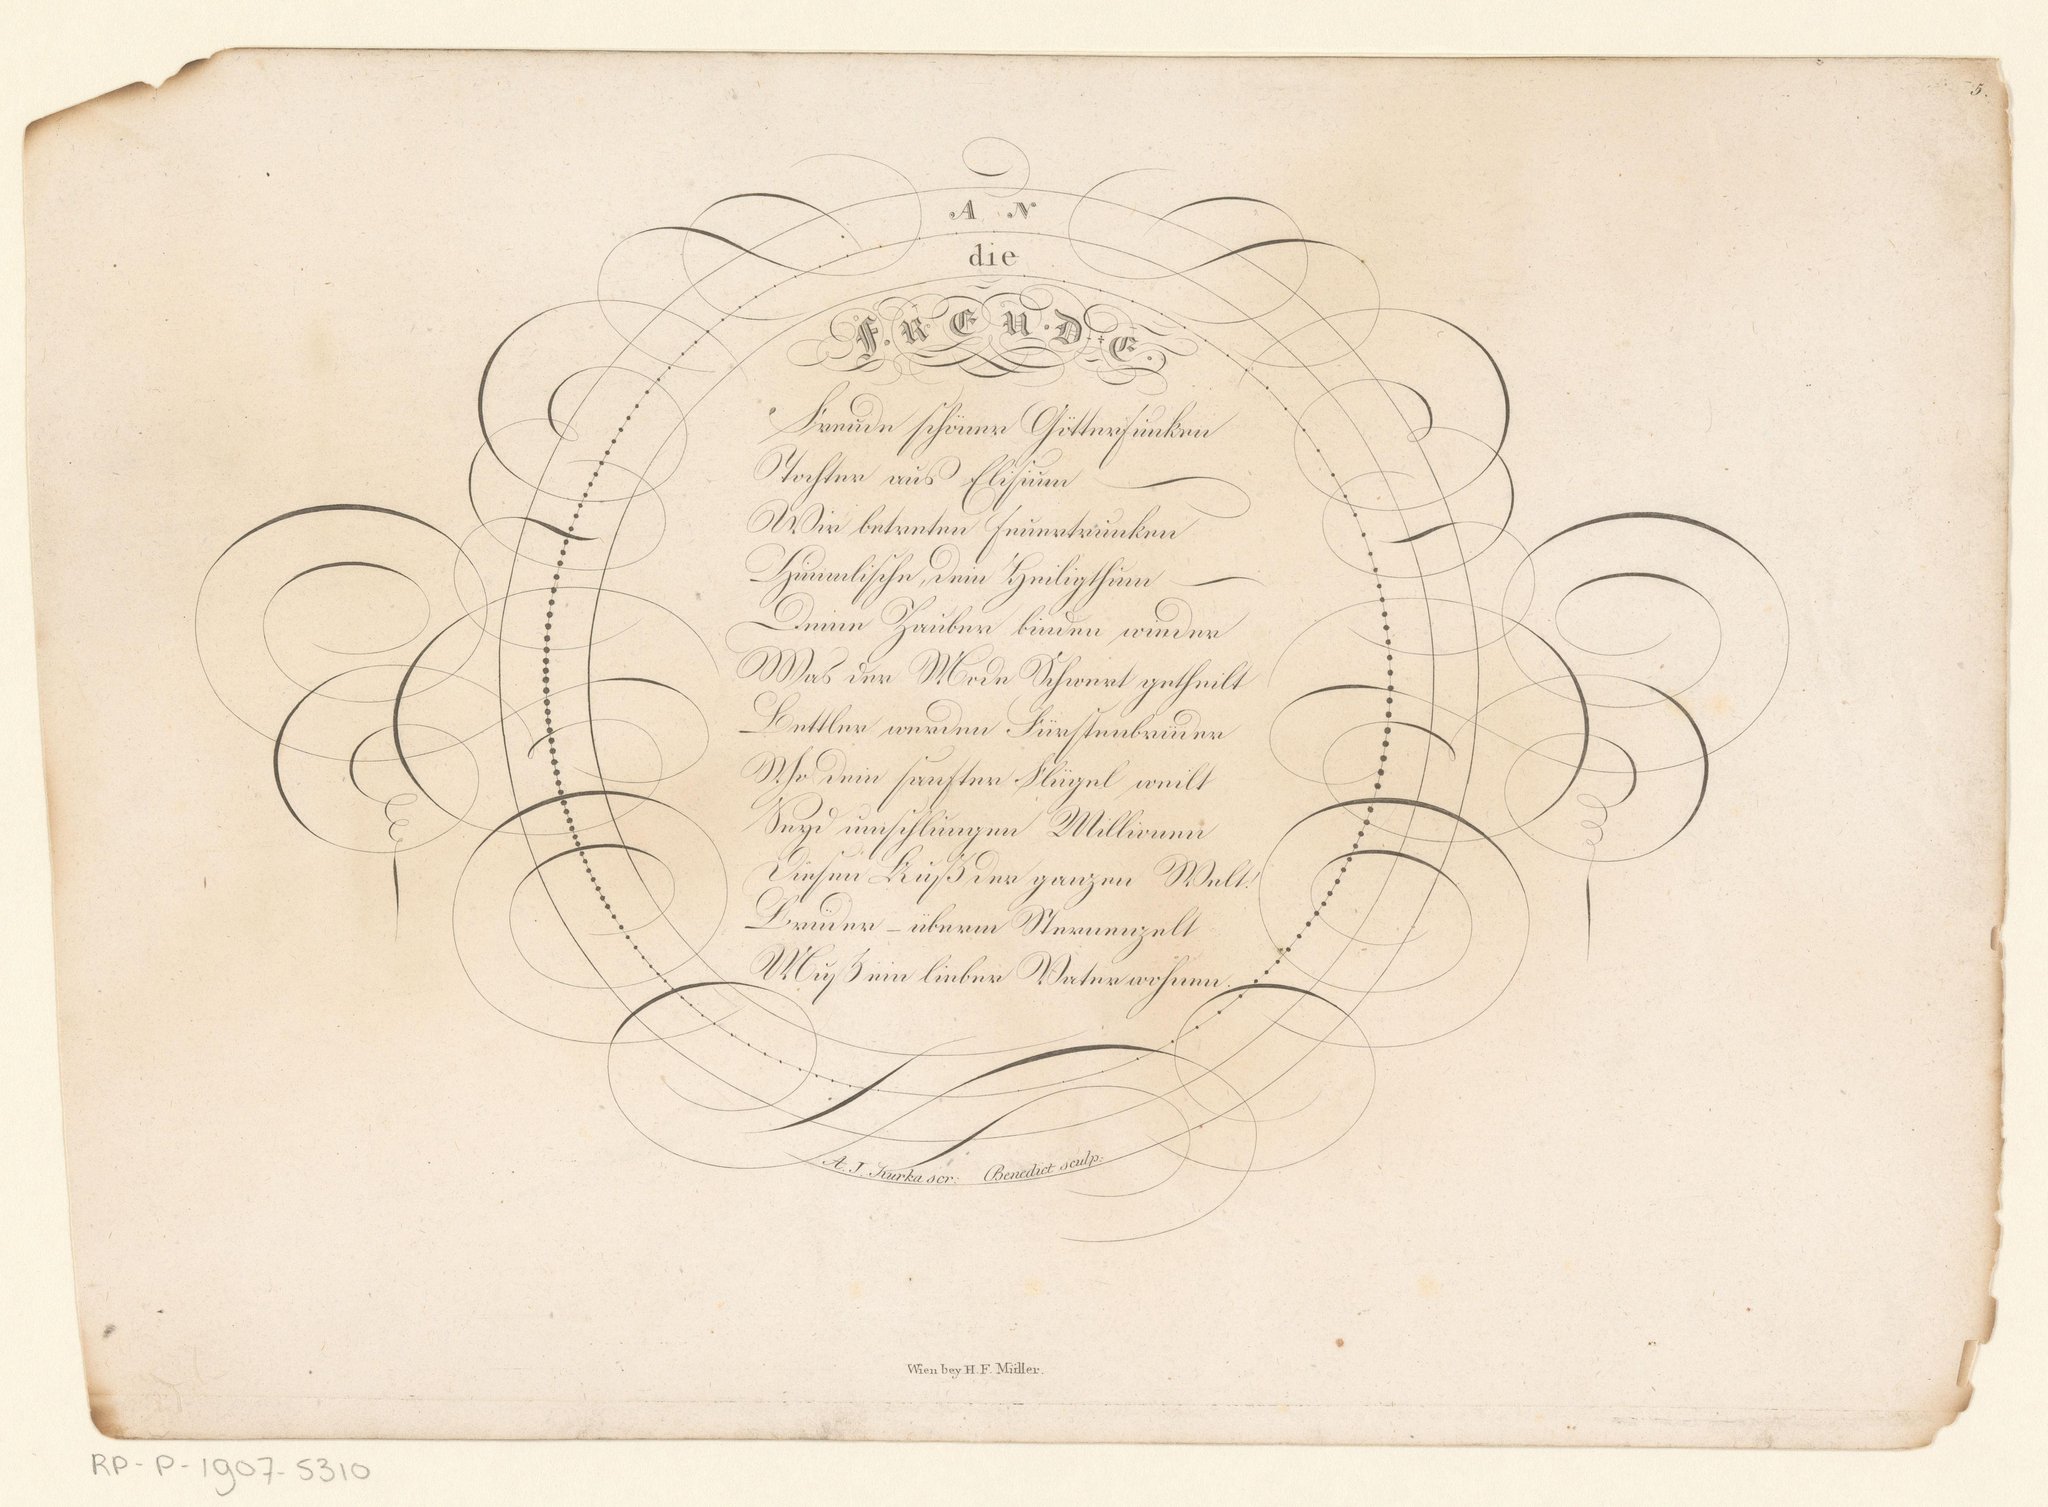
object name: ornament print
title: Schrijfvoorbeeld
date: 1795-1850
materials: paper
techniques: engraving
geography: vienna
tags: calligraphy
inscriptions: collector's mark: Lugt 2228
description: Gekalligrafeerde tekst: An die Freude (...)